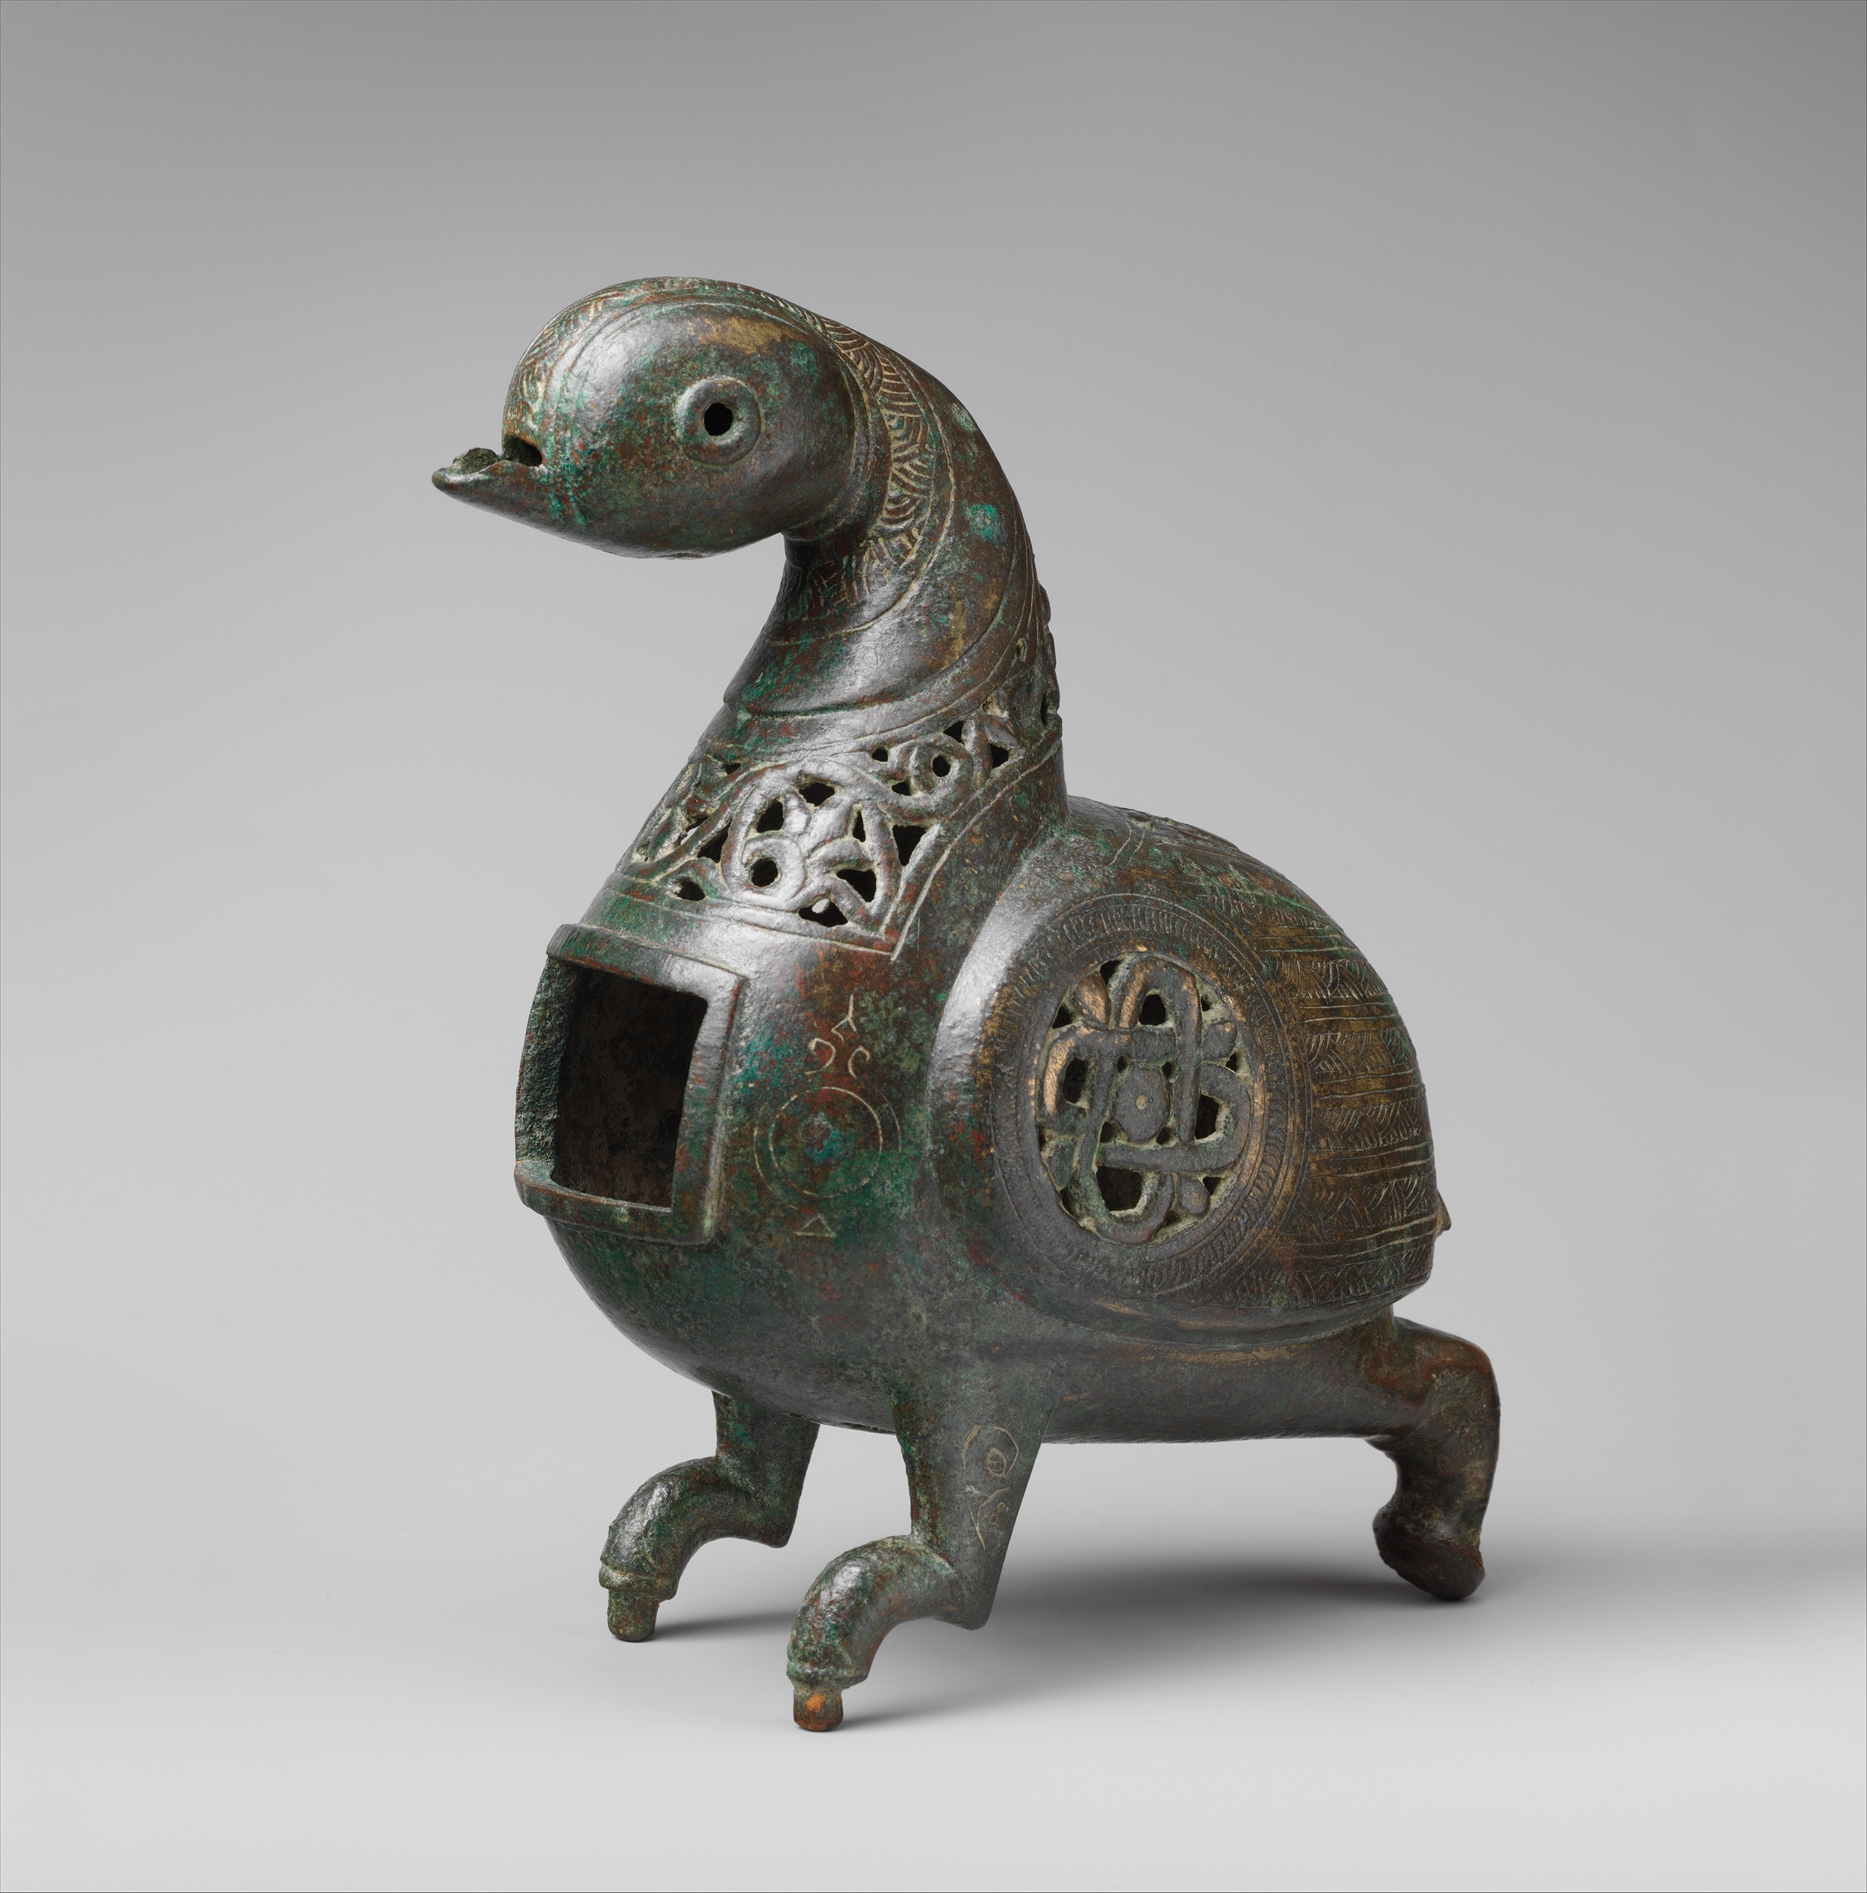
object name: incense burner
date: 1101-1200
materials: brass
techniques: casting, chasing, engraving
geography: iran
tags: birds